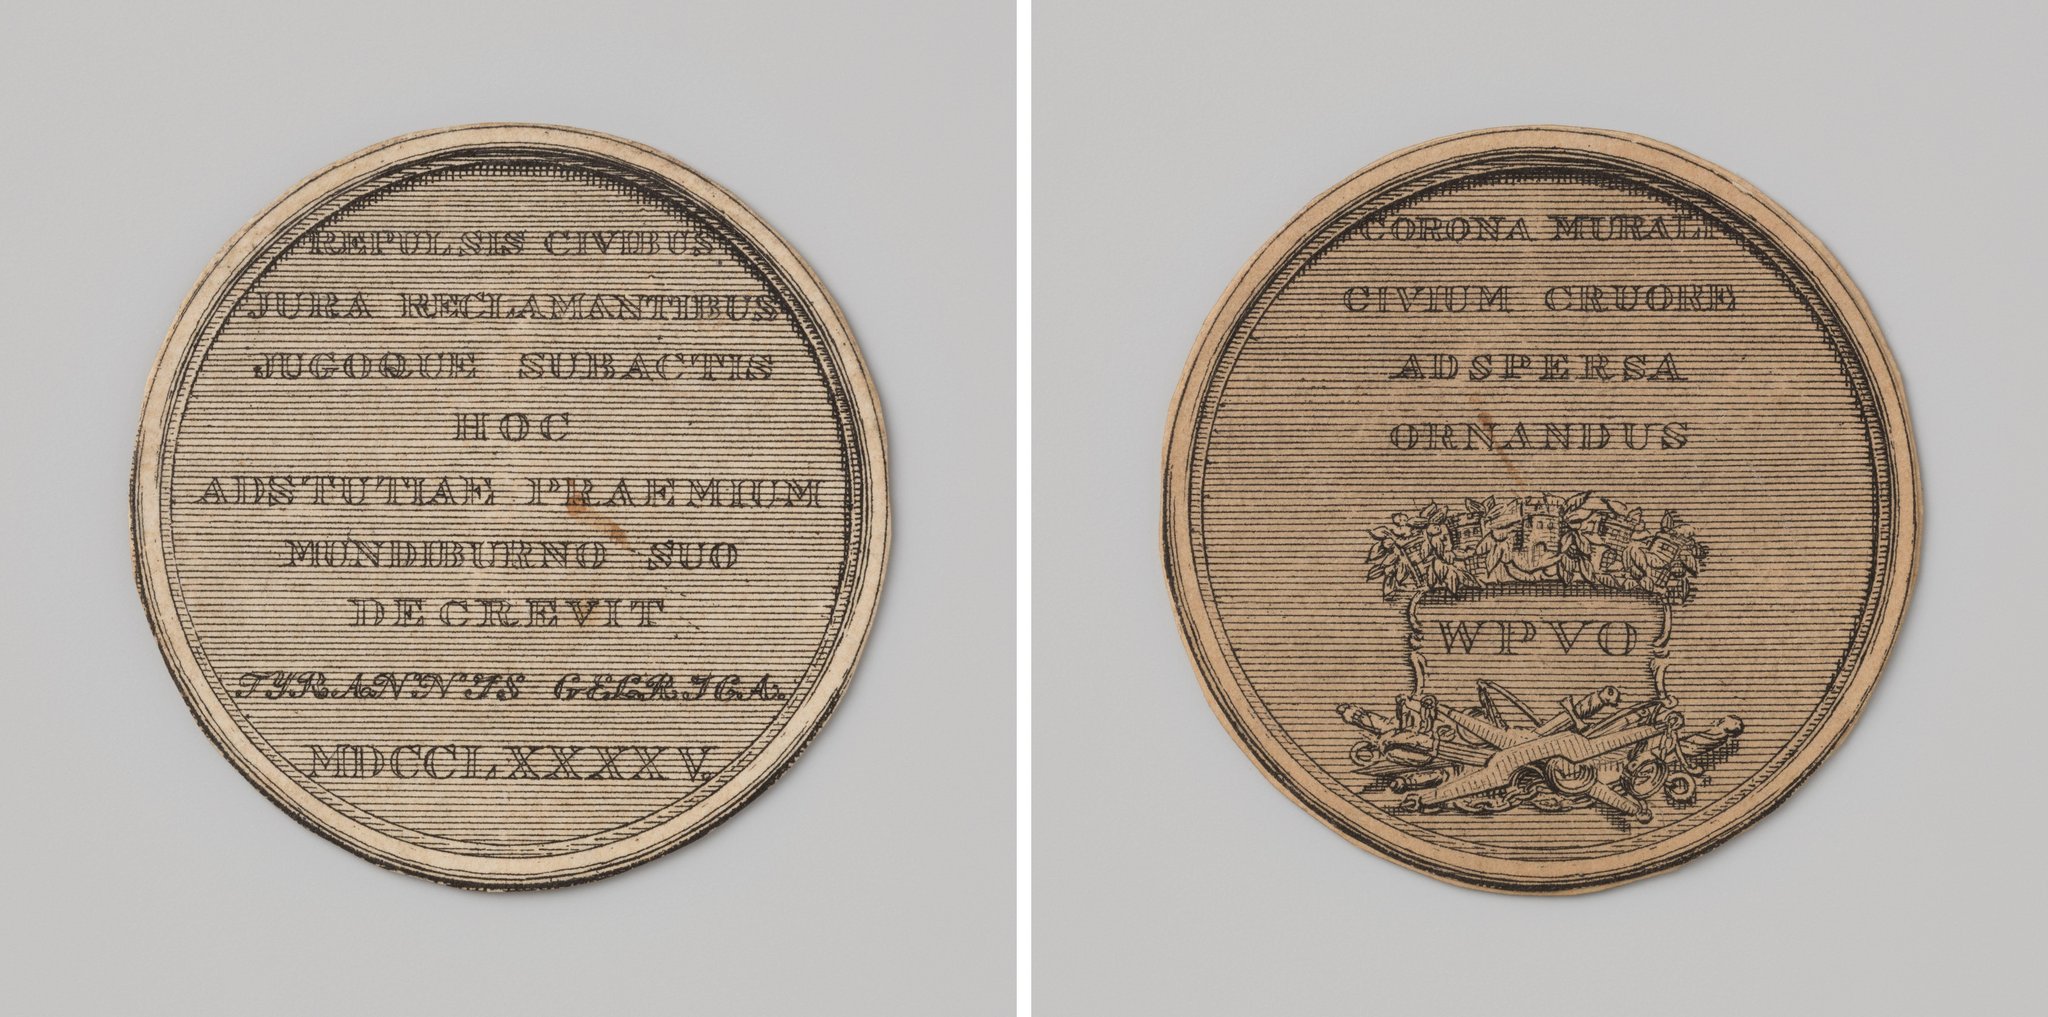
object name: history medal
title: Patriotse woelingen in Gelderland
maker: Anonymous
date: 1785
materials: cardboard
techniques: printing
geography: netherlands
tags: gelderland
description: Voorzijde: opschrift. Keerzijde: muurkroon versierd met 6 oranjeappels en bladeren boven opschrift en stapel jukken, ketens, zwaarden e.d.